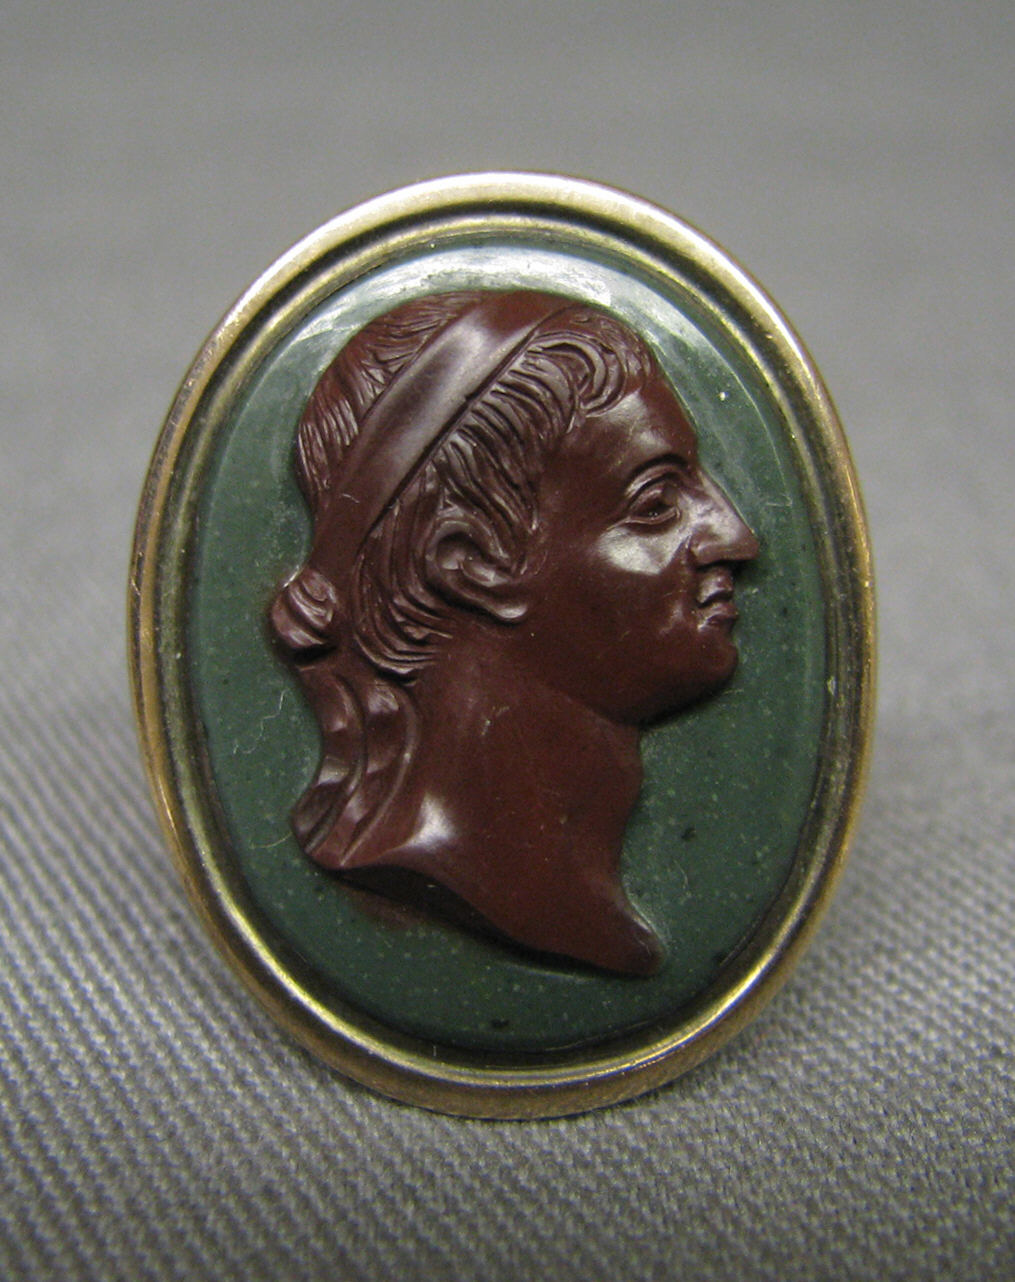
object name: ring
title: Head of a hero wearing a fillet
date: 1777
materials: gold, jasper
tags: heads